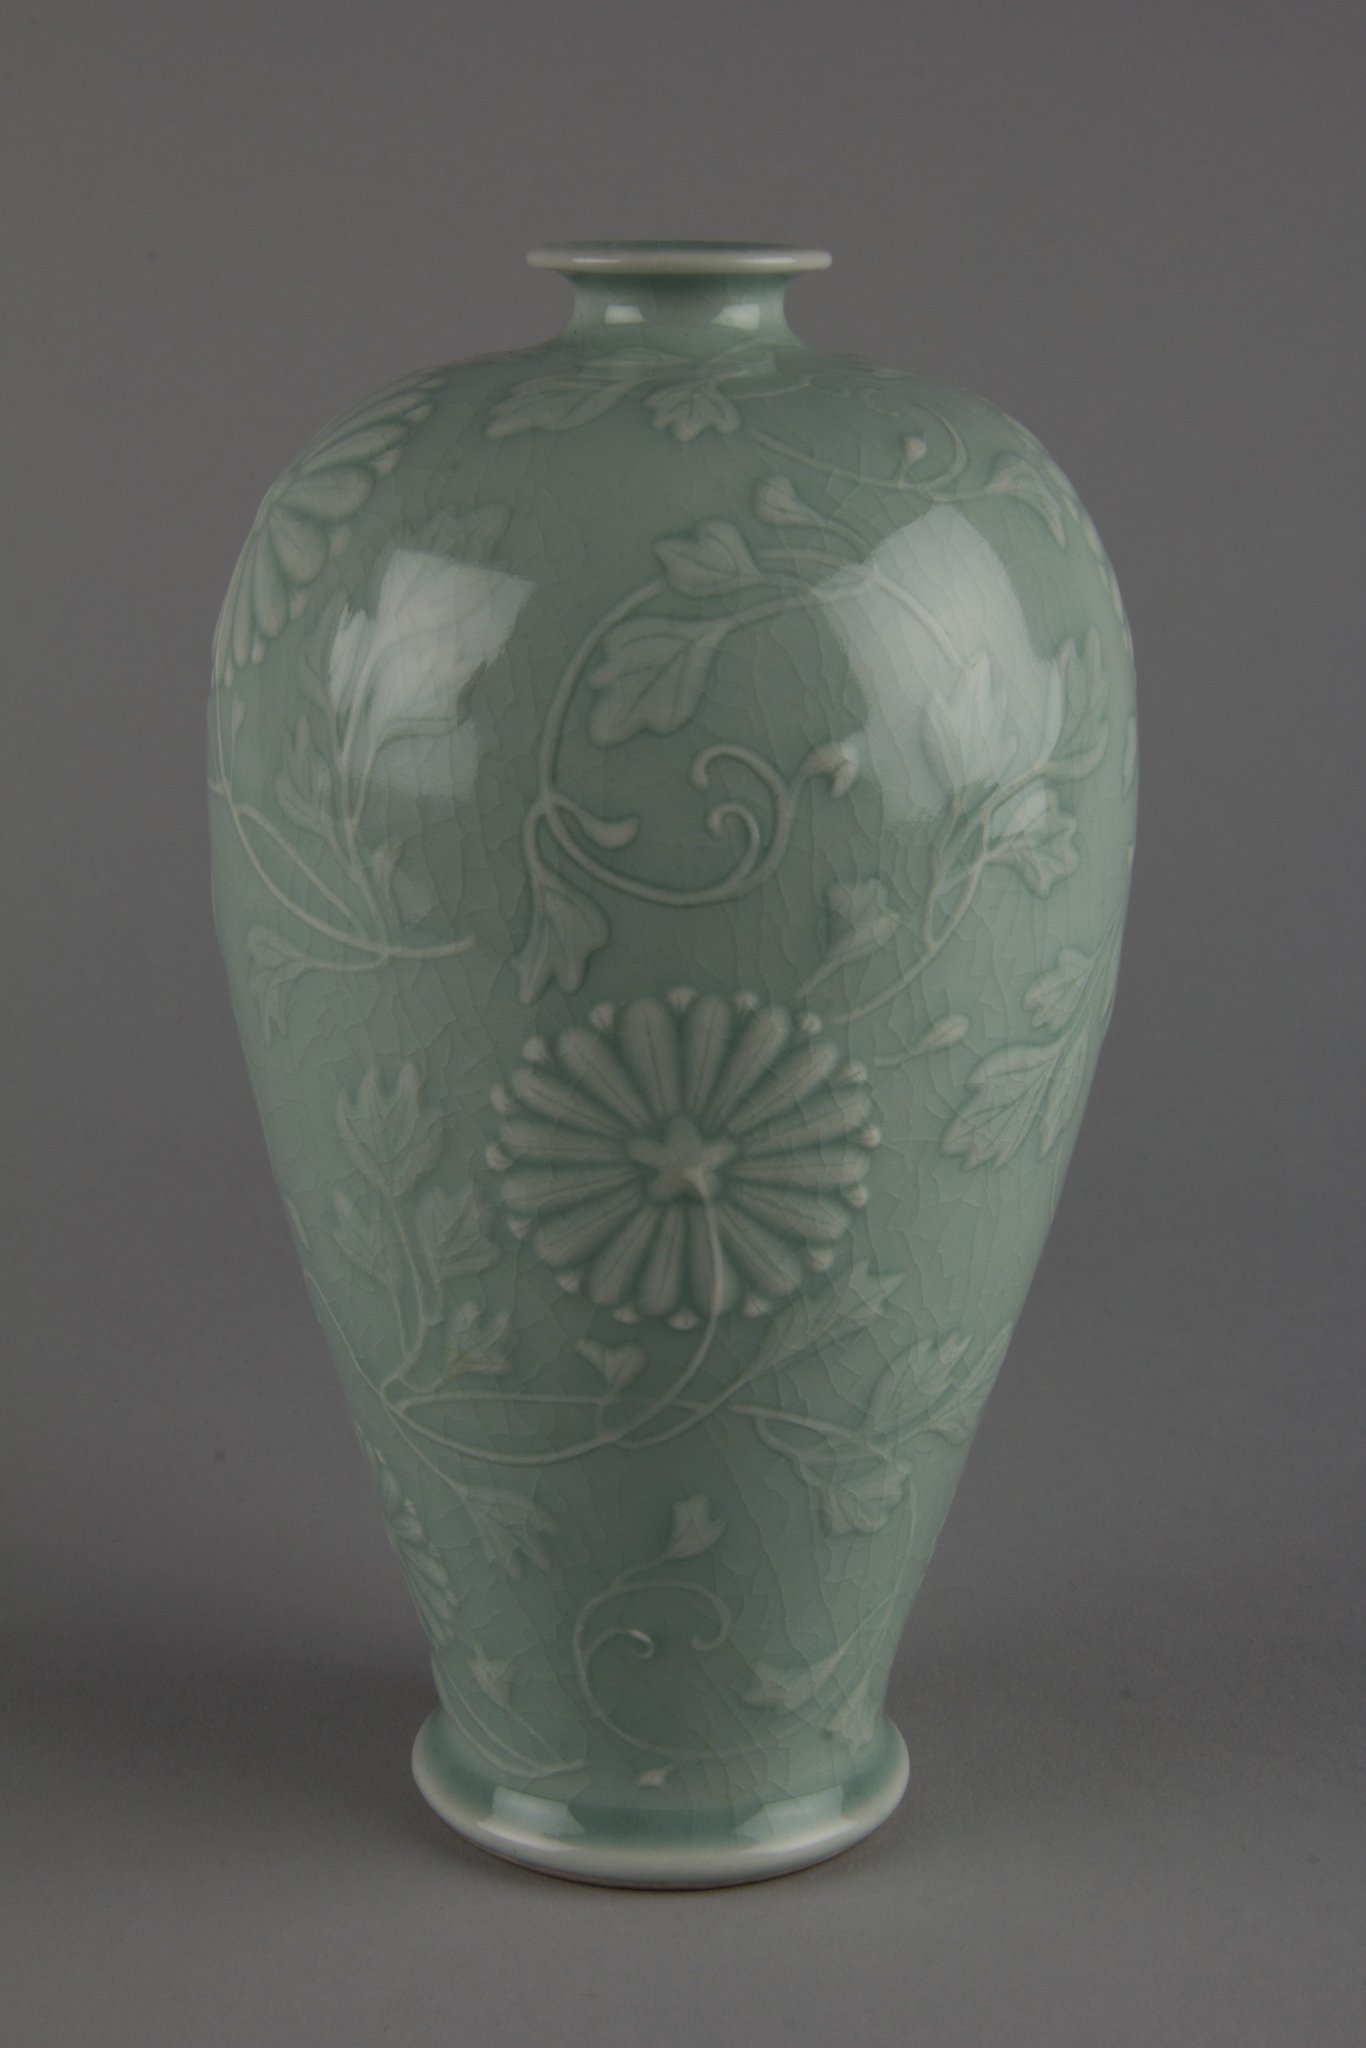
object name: vase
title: Meiping vase with floral scrolls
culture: chinese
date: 1701-1800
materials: ceramic glaze, glaze, porcelain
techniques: relief